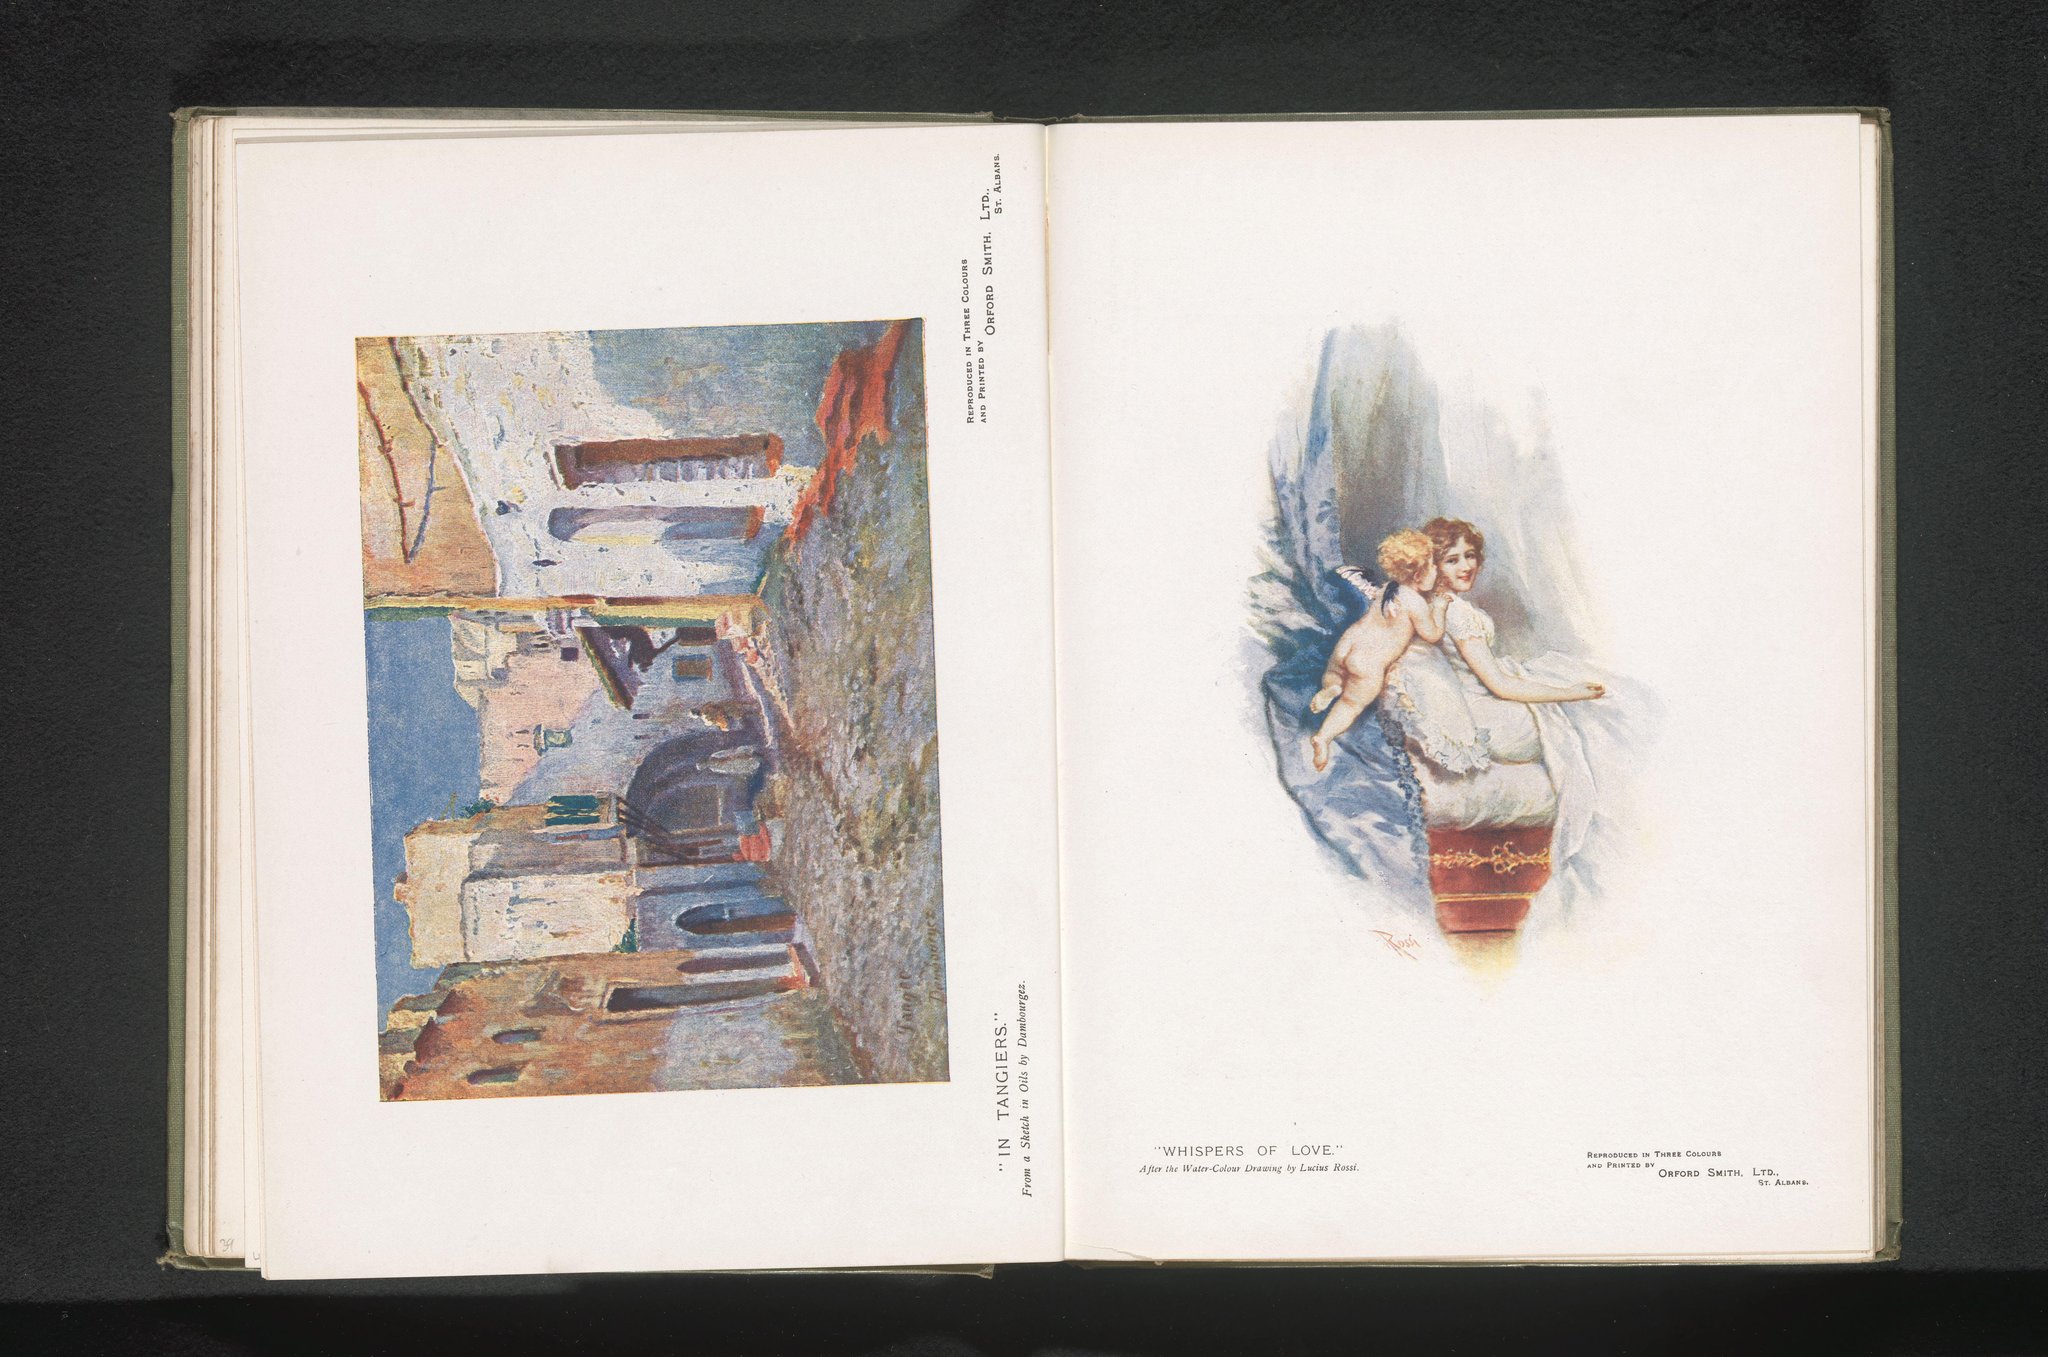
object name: reproduction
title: Whispers of love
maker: lucius rossi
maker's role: painter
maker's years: 1846-1913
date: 1893-1898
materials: paper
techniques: three-color autotype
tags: angel(s) represented as child(ren)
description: Prent op derde ongenummerde pagina na pagina 52.